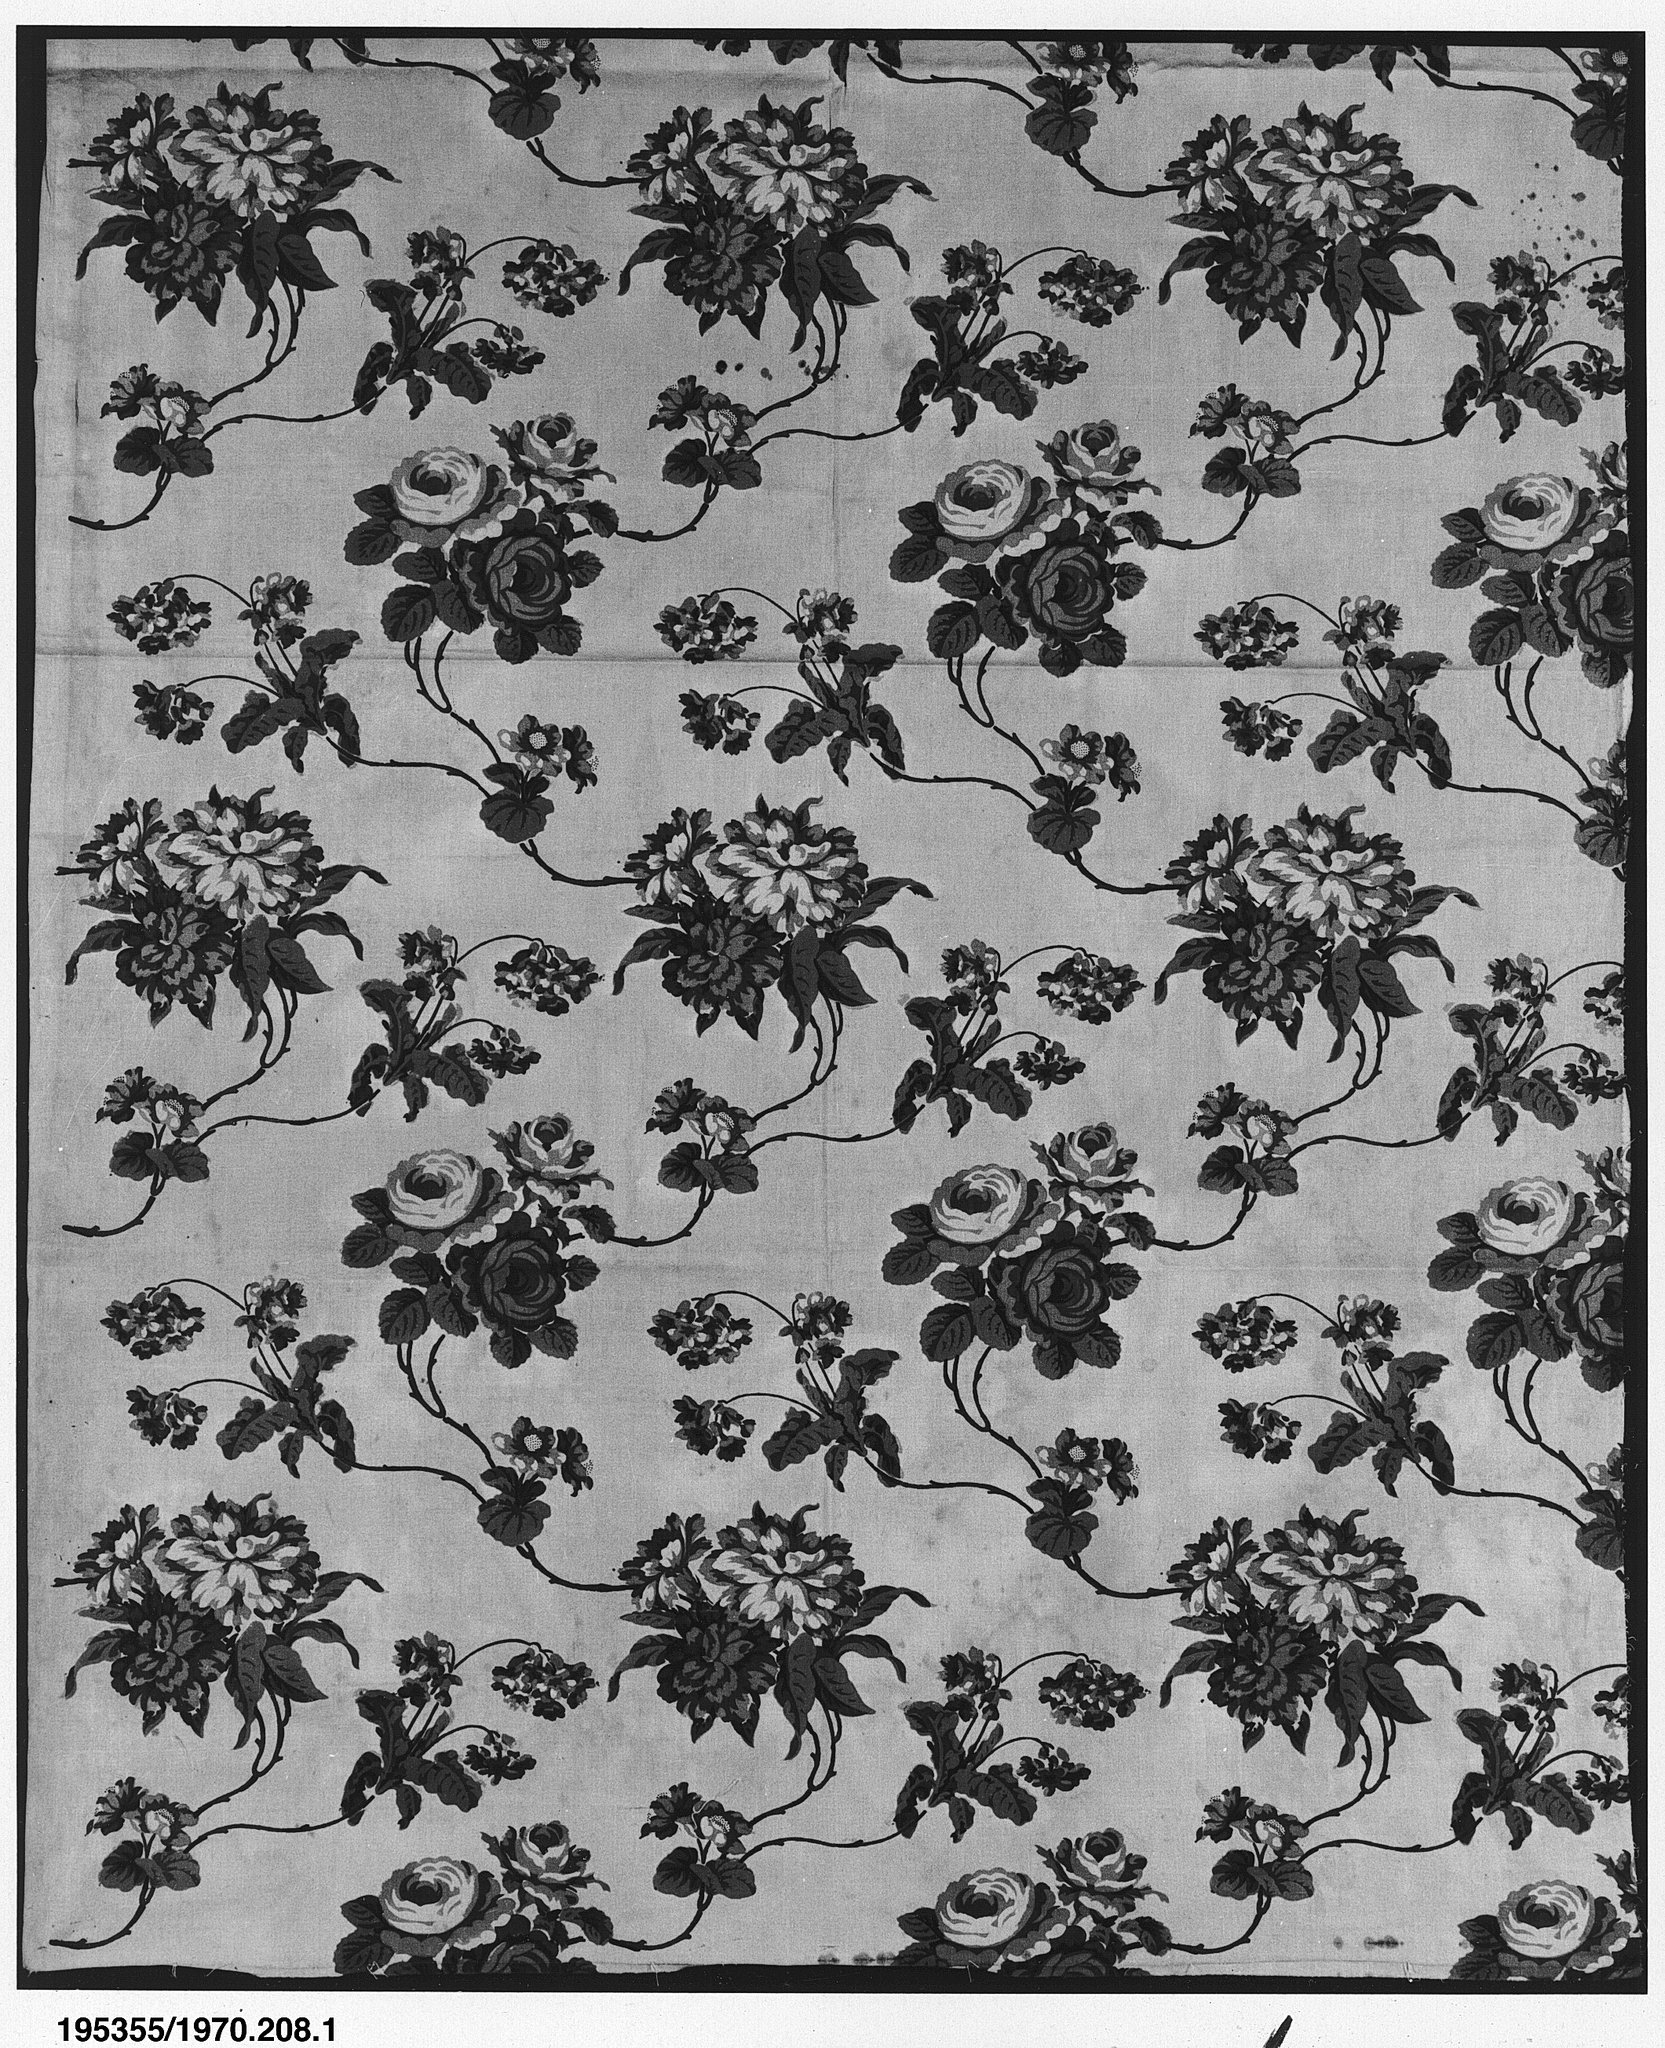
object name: piece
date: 1801-1900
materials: cotton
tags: flowers,leaves